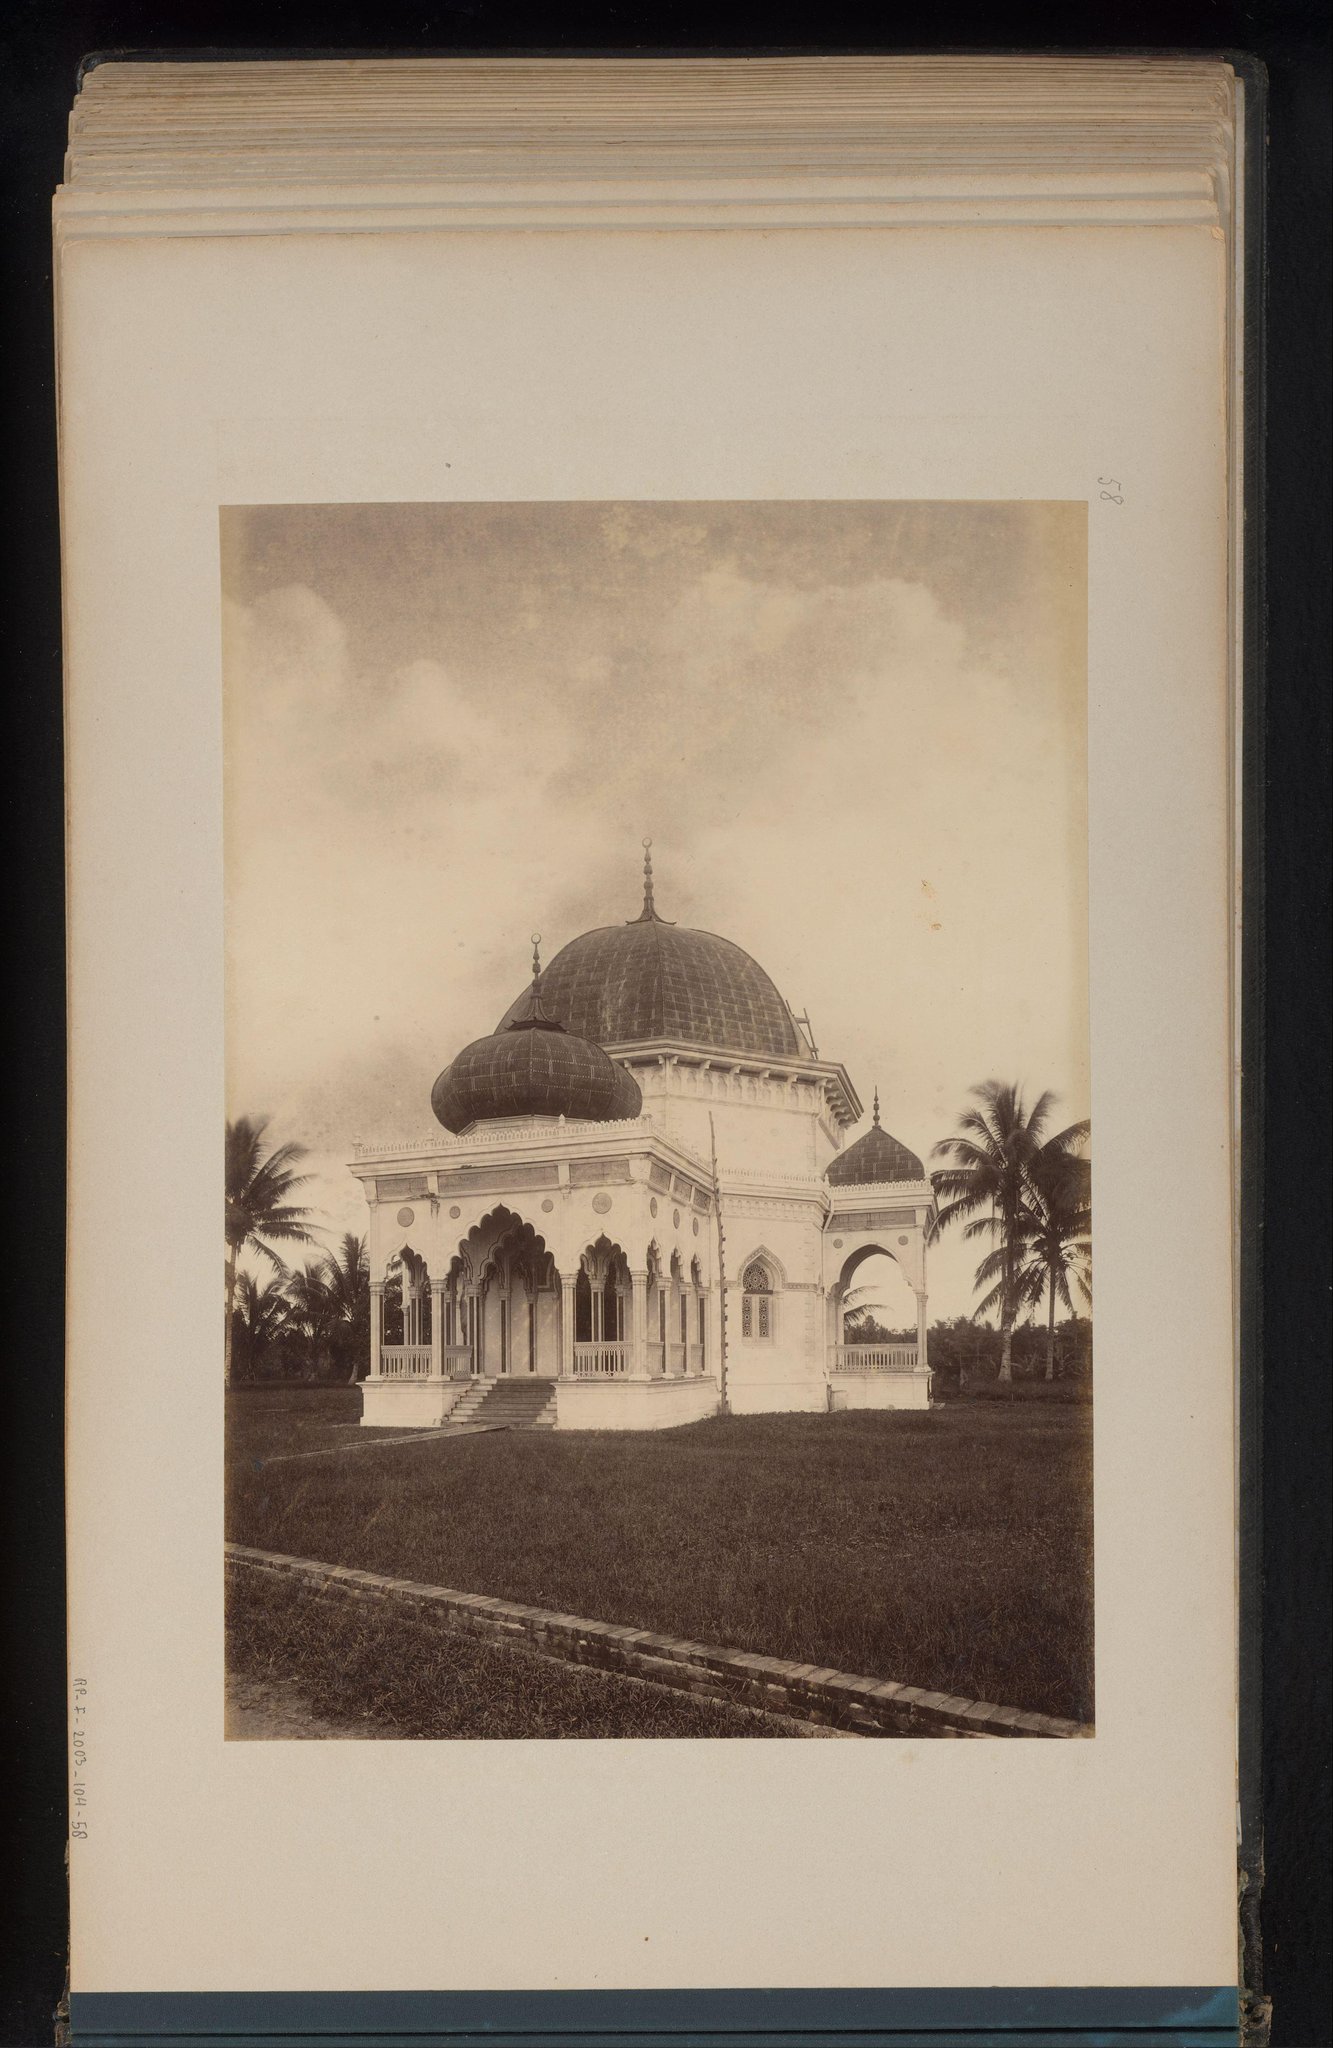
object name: album leaf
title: Gezicht op een moskee in Bindjai Lankat, Sumatra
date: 1890-1900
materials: cardboard, photographic support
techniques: albumen print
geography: bindjai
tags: temple, shrine ~ islam, mohammedanism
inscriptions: number: ‘58’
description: In de lijst van afbeeldingen wordt deze foto beschreven met de woorden "Moschee in Bindjey".